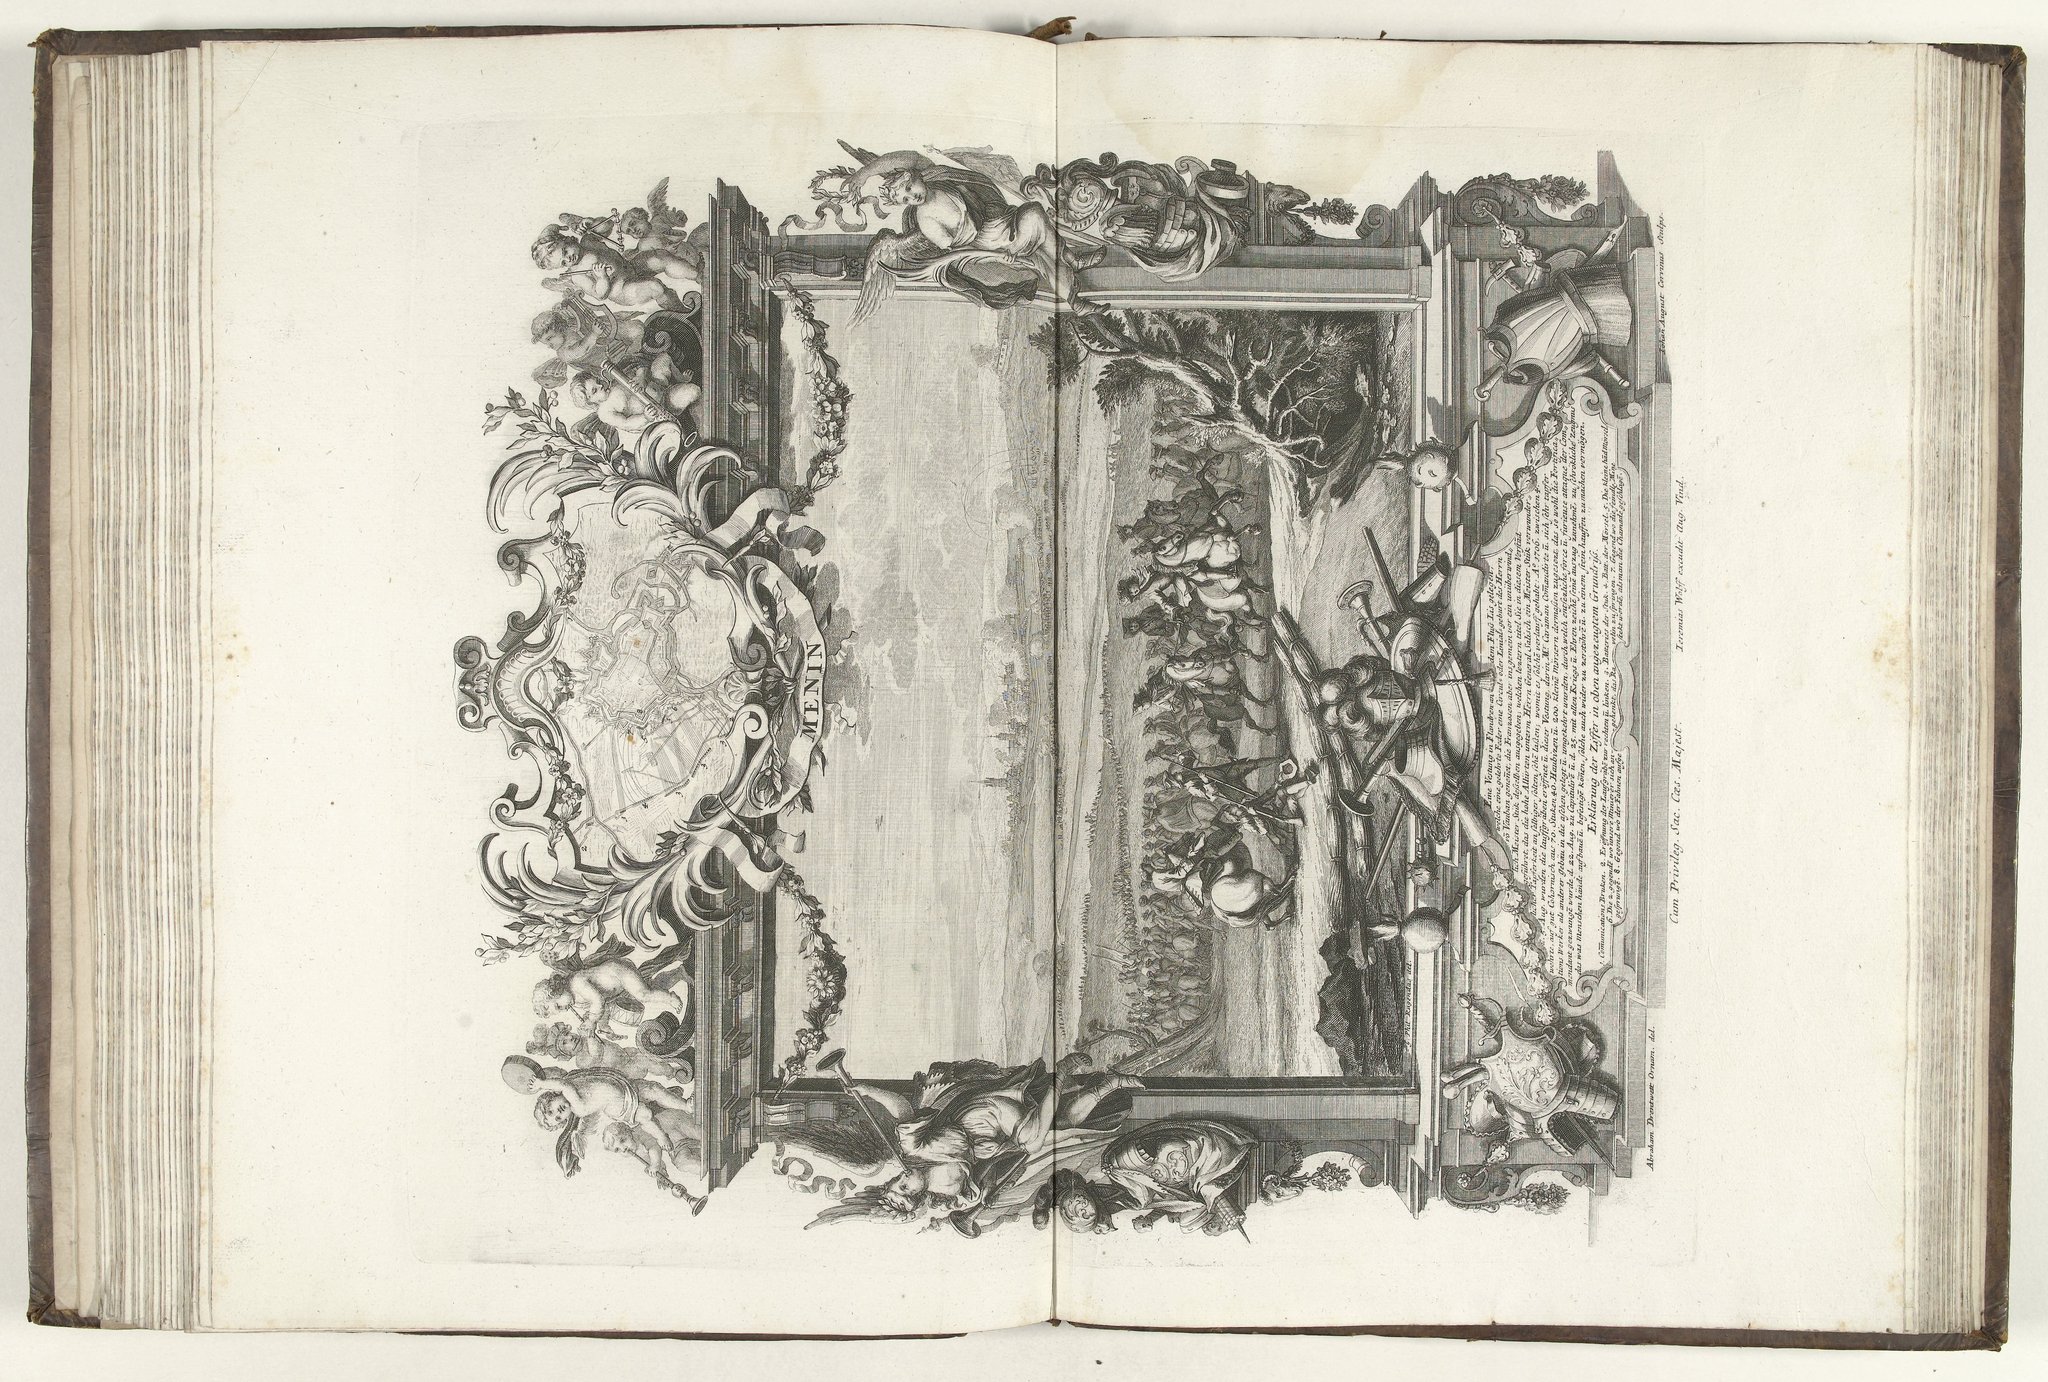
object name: history print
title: Menin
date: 1712-1715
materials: paper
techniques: engraving, etching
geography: augsburg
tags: siege, position war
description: Beleg en inname van Menen door de Geallieerden, belegerd vanaf 23 juli, ingenomen op 22 augustus 1706. In de centrale voorstelling het beleg, in een rijk versierde ornamentele omlijsting met bovenaan een cartouche met een plattegrond van het beleg. Onderaan een cartouche met de beschrijving van de gebeurtenissen in het Duits. Blad in de gebonden verzameling platen uitgebracht onder de titel: Repraesentatio belli ... Der Spanische Successions-Krieg [ca. 1720].